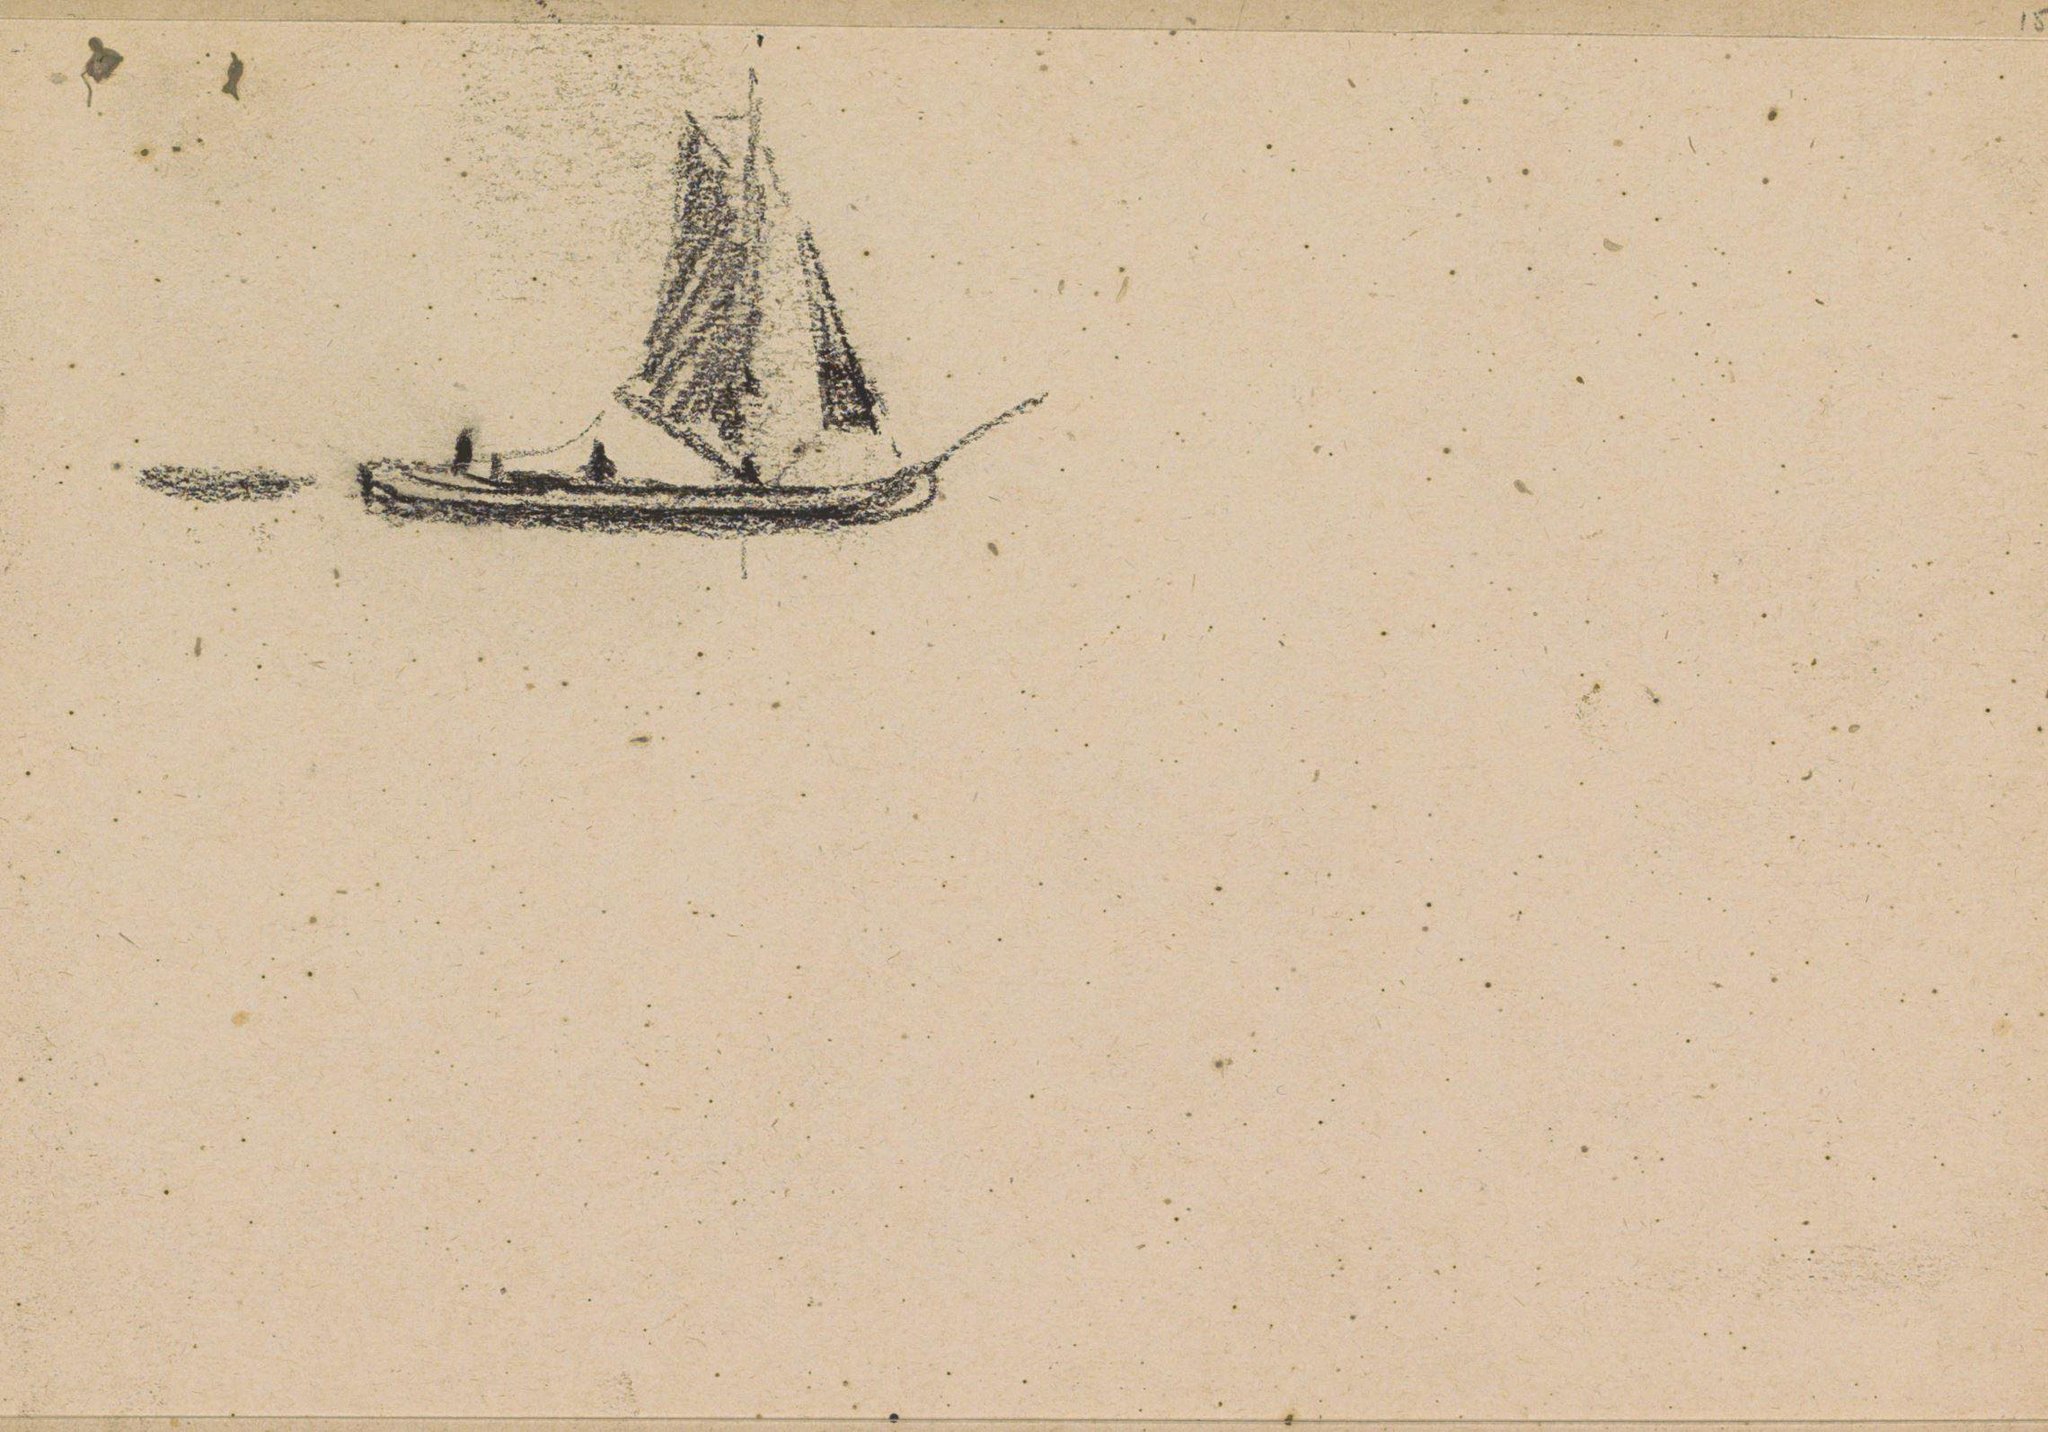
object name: sketchbook leaf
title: Bemand zeilschip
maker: willem witsen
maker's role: draughtsman, painter, print maker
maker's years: 1860-1923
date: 1906-1907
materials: chalk, paper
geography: wijk bij duurstede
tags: sailing-ship, sailing-boat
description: Pagina 15 uit een schetsboek met 25 bladen.